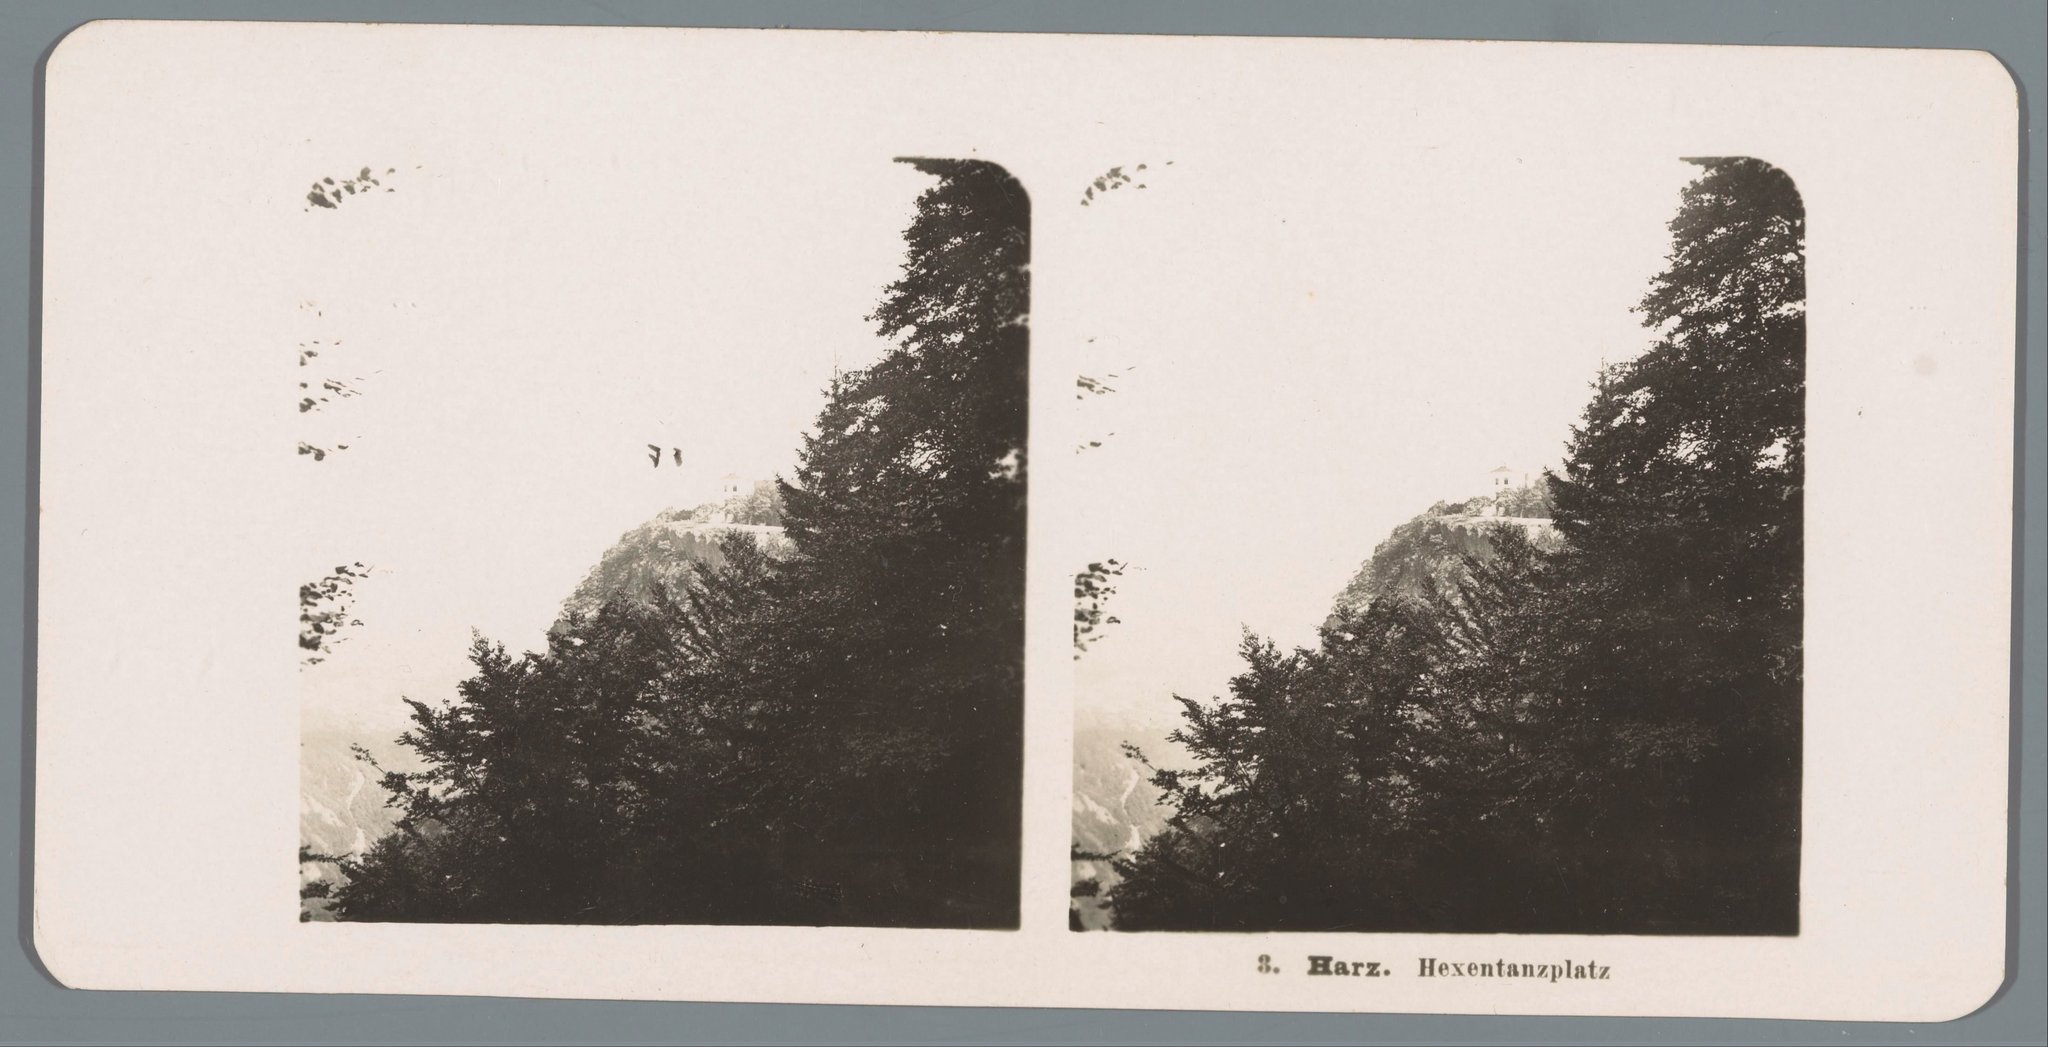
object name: stereograph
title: Harz. Hexentanzplatz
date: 1906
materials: cardboard, photographic support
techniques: gelatin silver print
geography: harz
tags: mountain-top, peak, mountains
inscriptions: number: ‘3.’, inscription: ‘Neue Photographische Gesellschaft A.-G., Steglitz-Berlin 1906.’